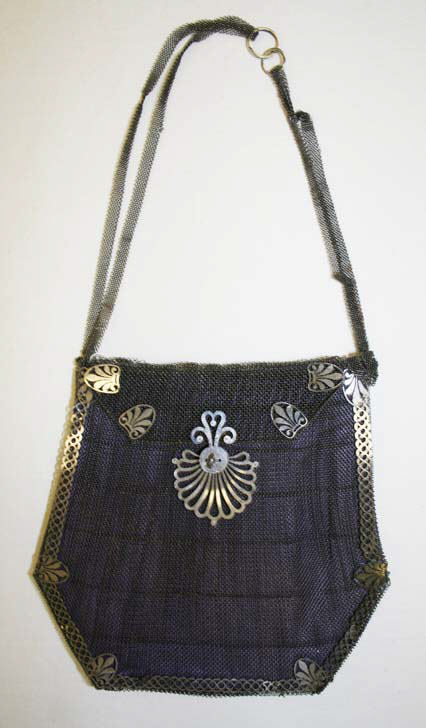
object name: purse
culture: french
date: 1800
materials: silk, steel